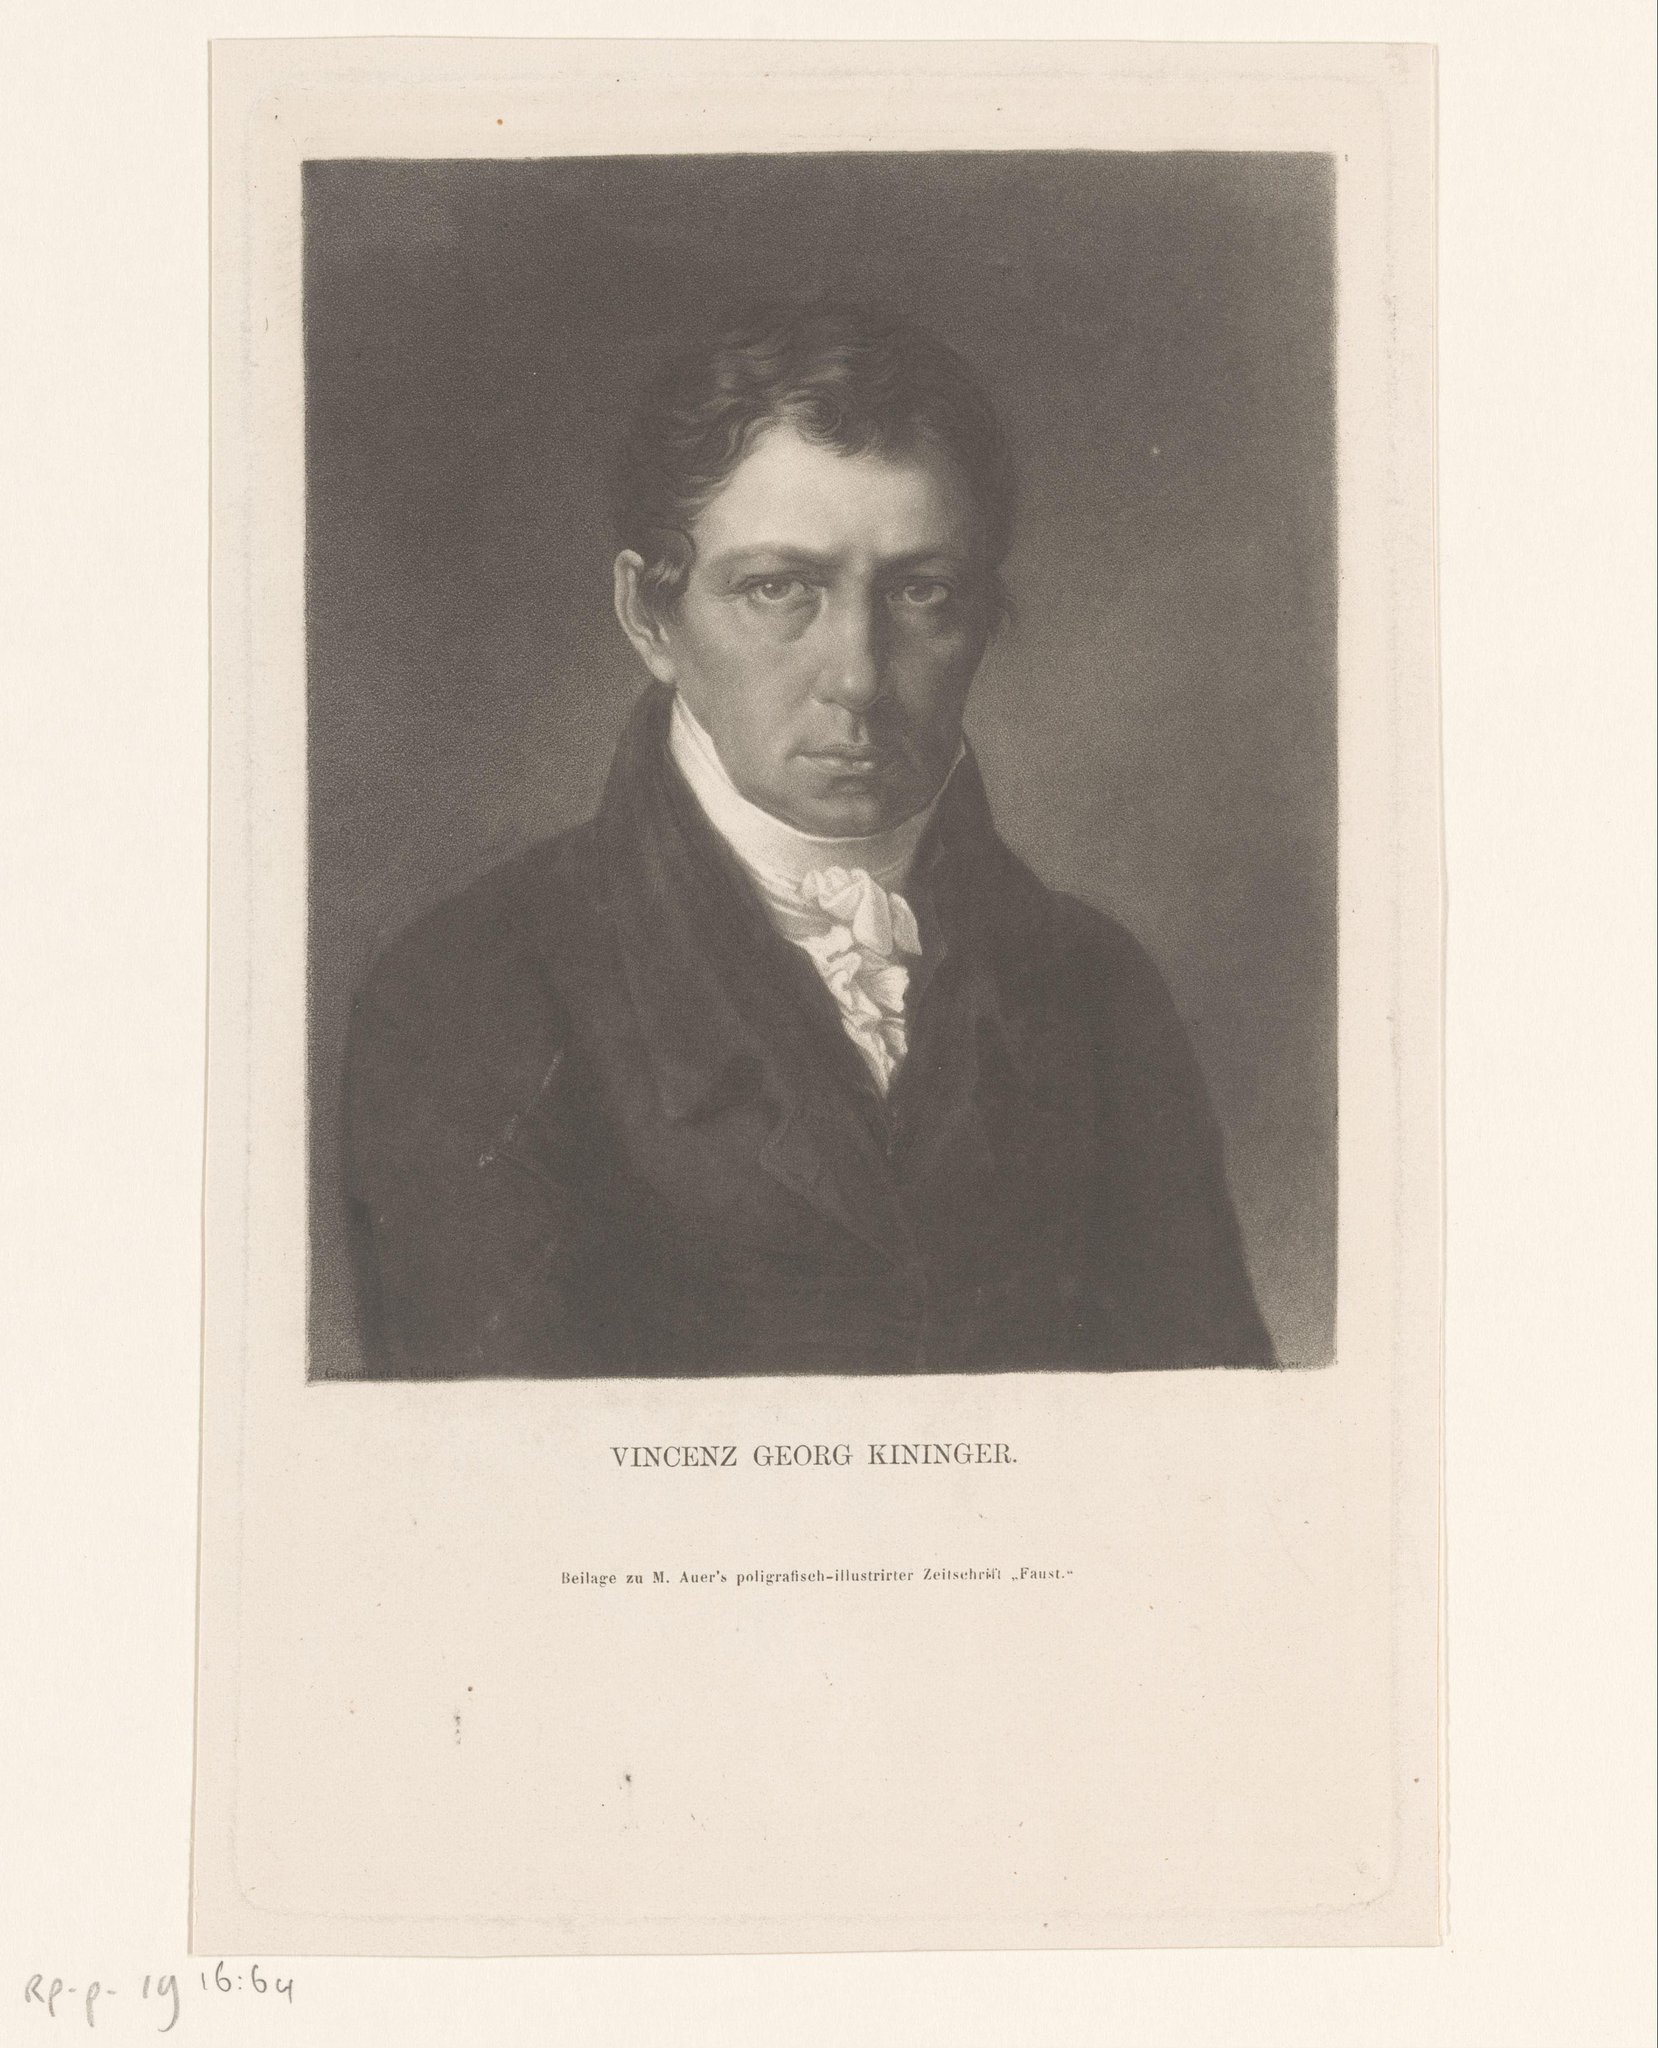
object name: print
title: Portret van Vincenz Georg Kininger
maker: christian mayer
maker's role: print maker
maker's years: 1812-1870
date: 1822-1870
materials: paper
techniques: mezzotint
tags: vienna, painter, print maker, artist, vincenz georg kininger, historical persons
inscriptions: collector's mark: Lugt 2228